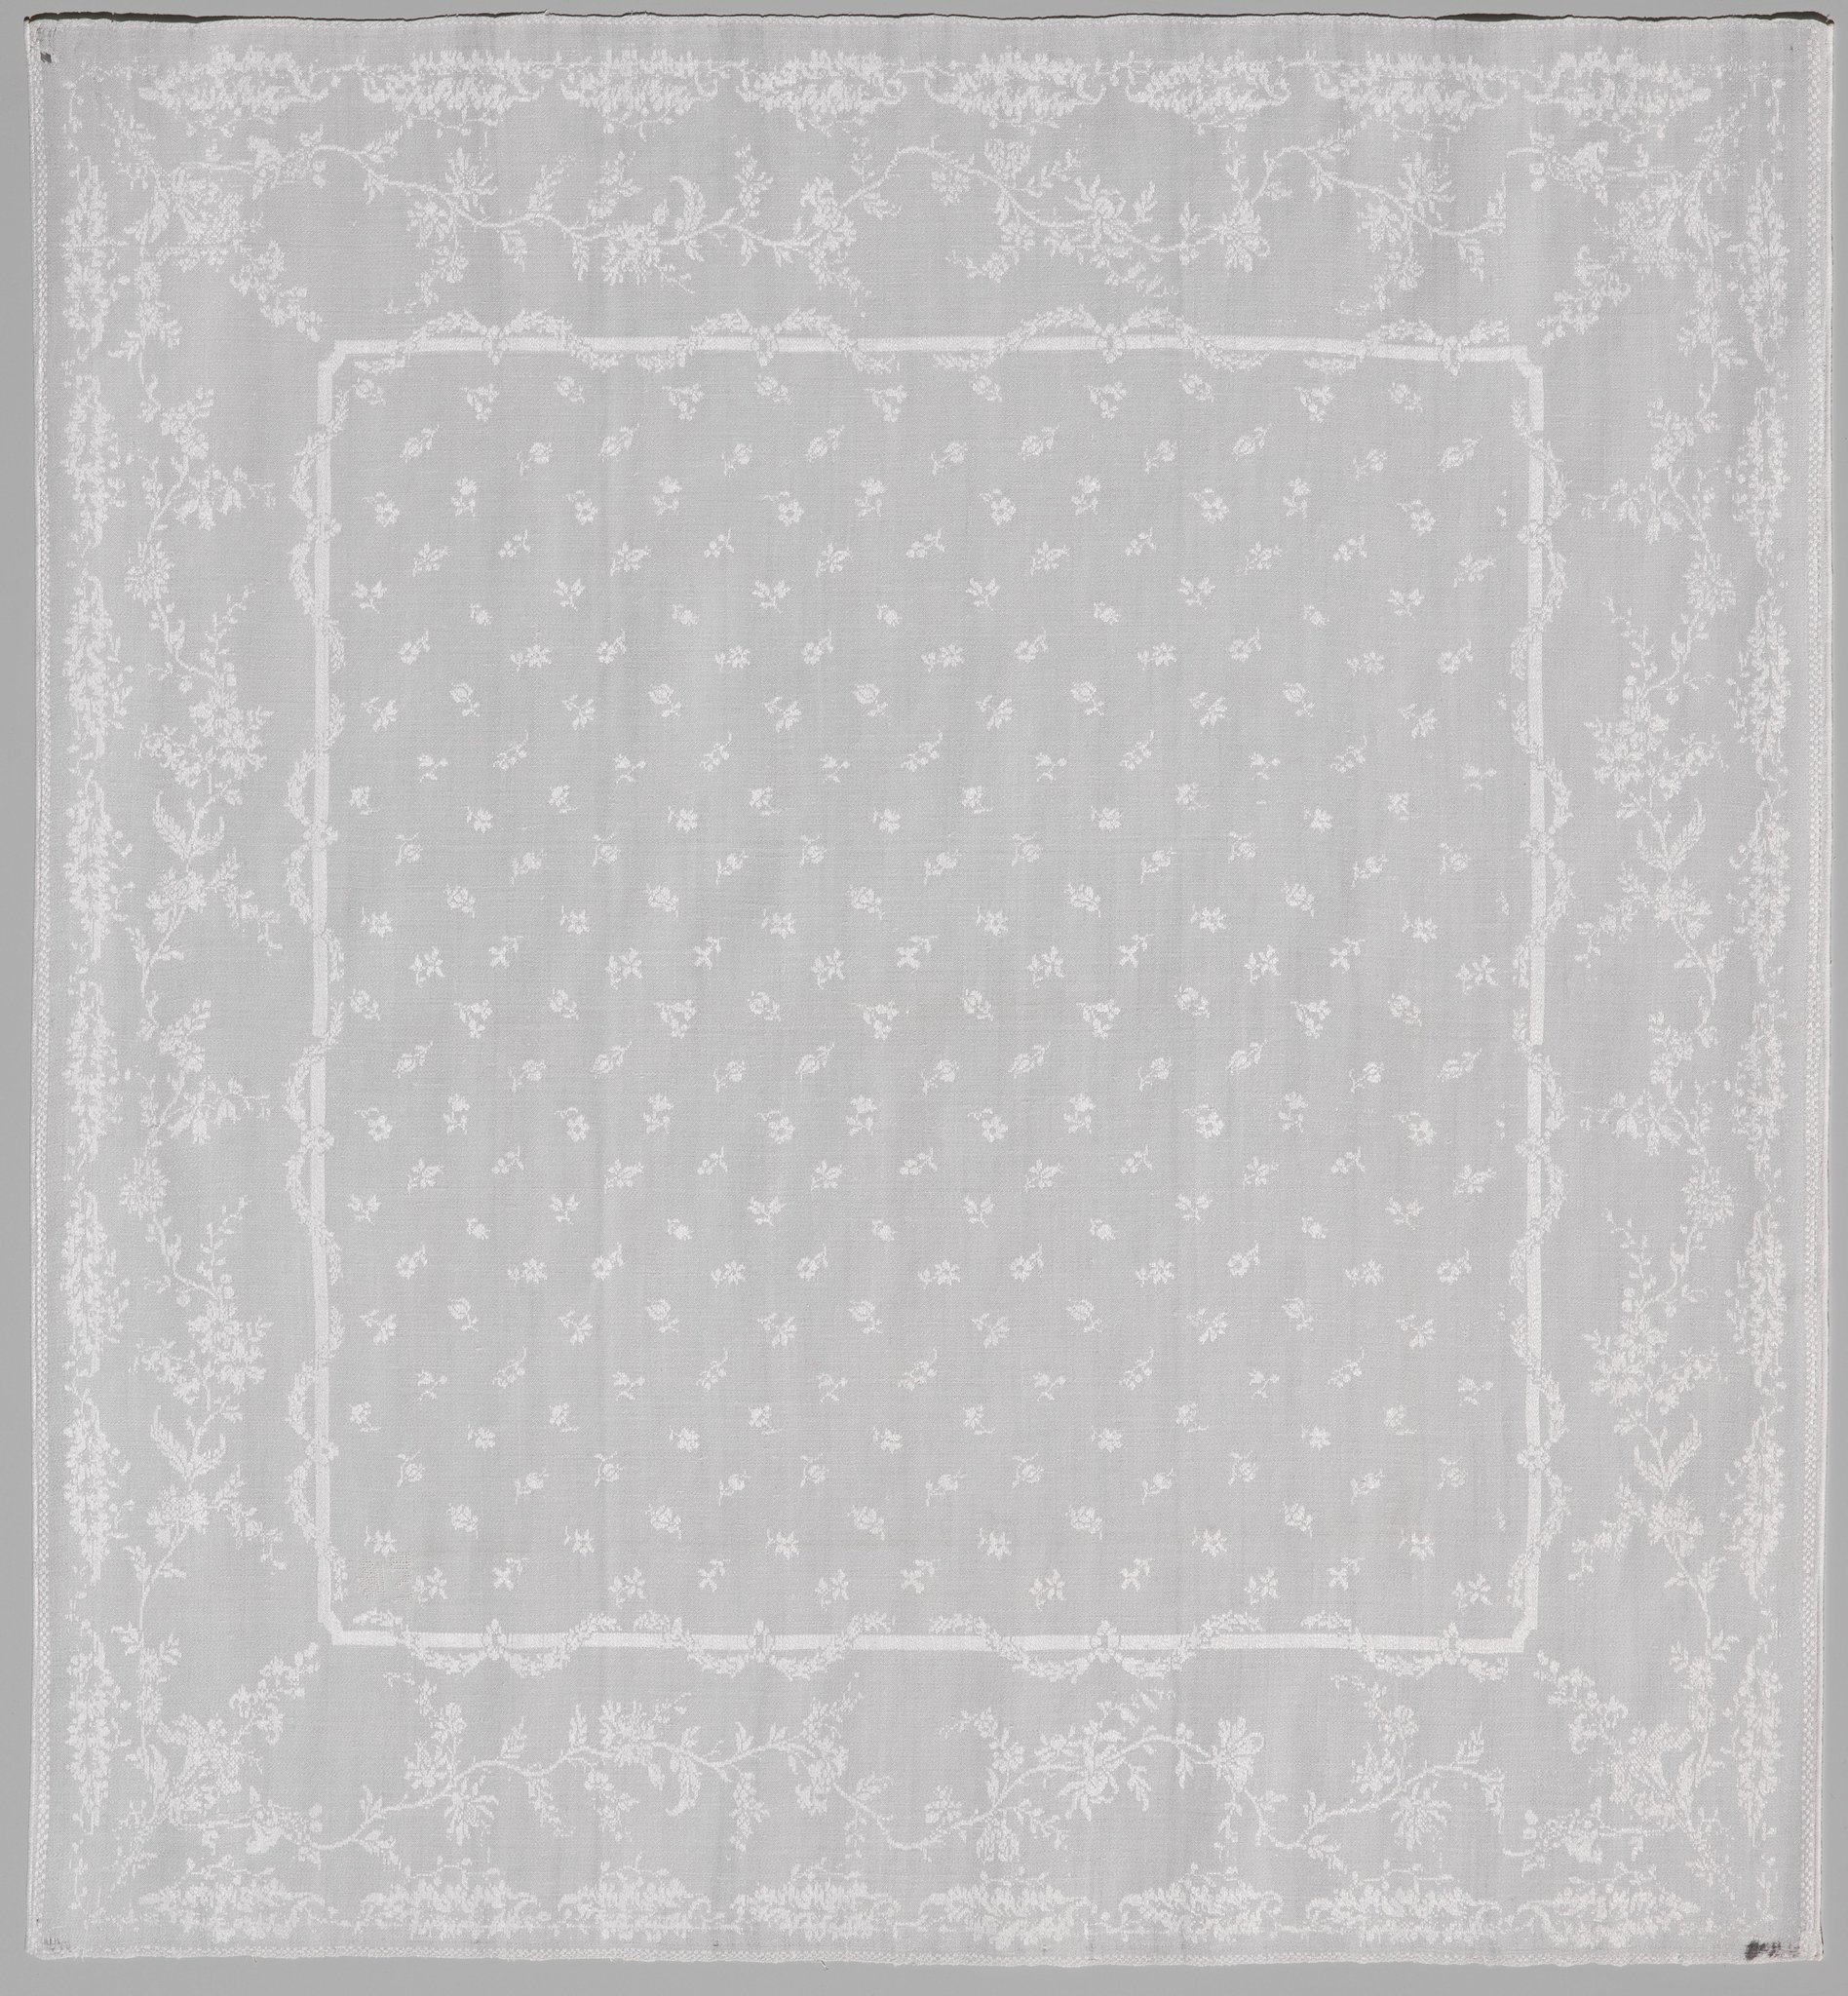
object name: napkin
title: Servet van linnendamast met een bloempatroon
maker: Anonymous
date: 1800-1850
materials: linen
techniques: damask, weave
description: Servet van linnendamast met gestrooide bloemen. Het servet hoort bij een servet (BK-1971-247-A).